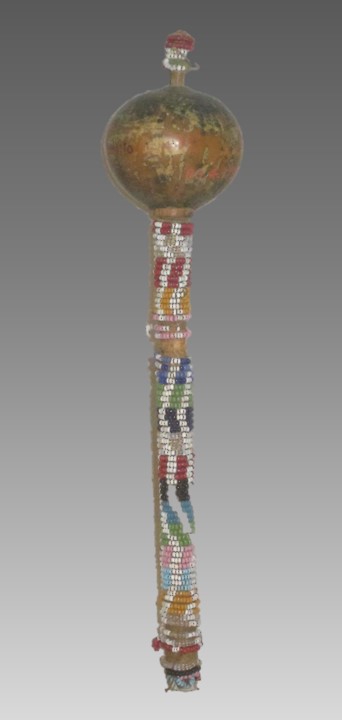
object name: rattle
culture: native american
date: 1801-1900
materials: cord, glass, leather, wood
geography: united states